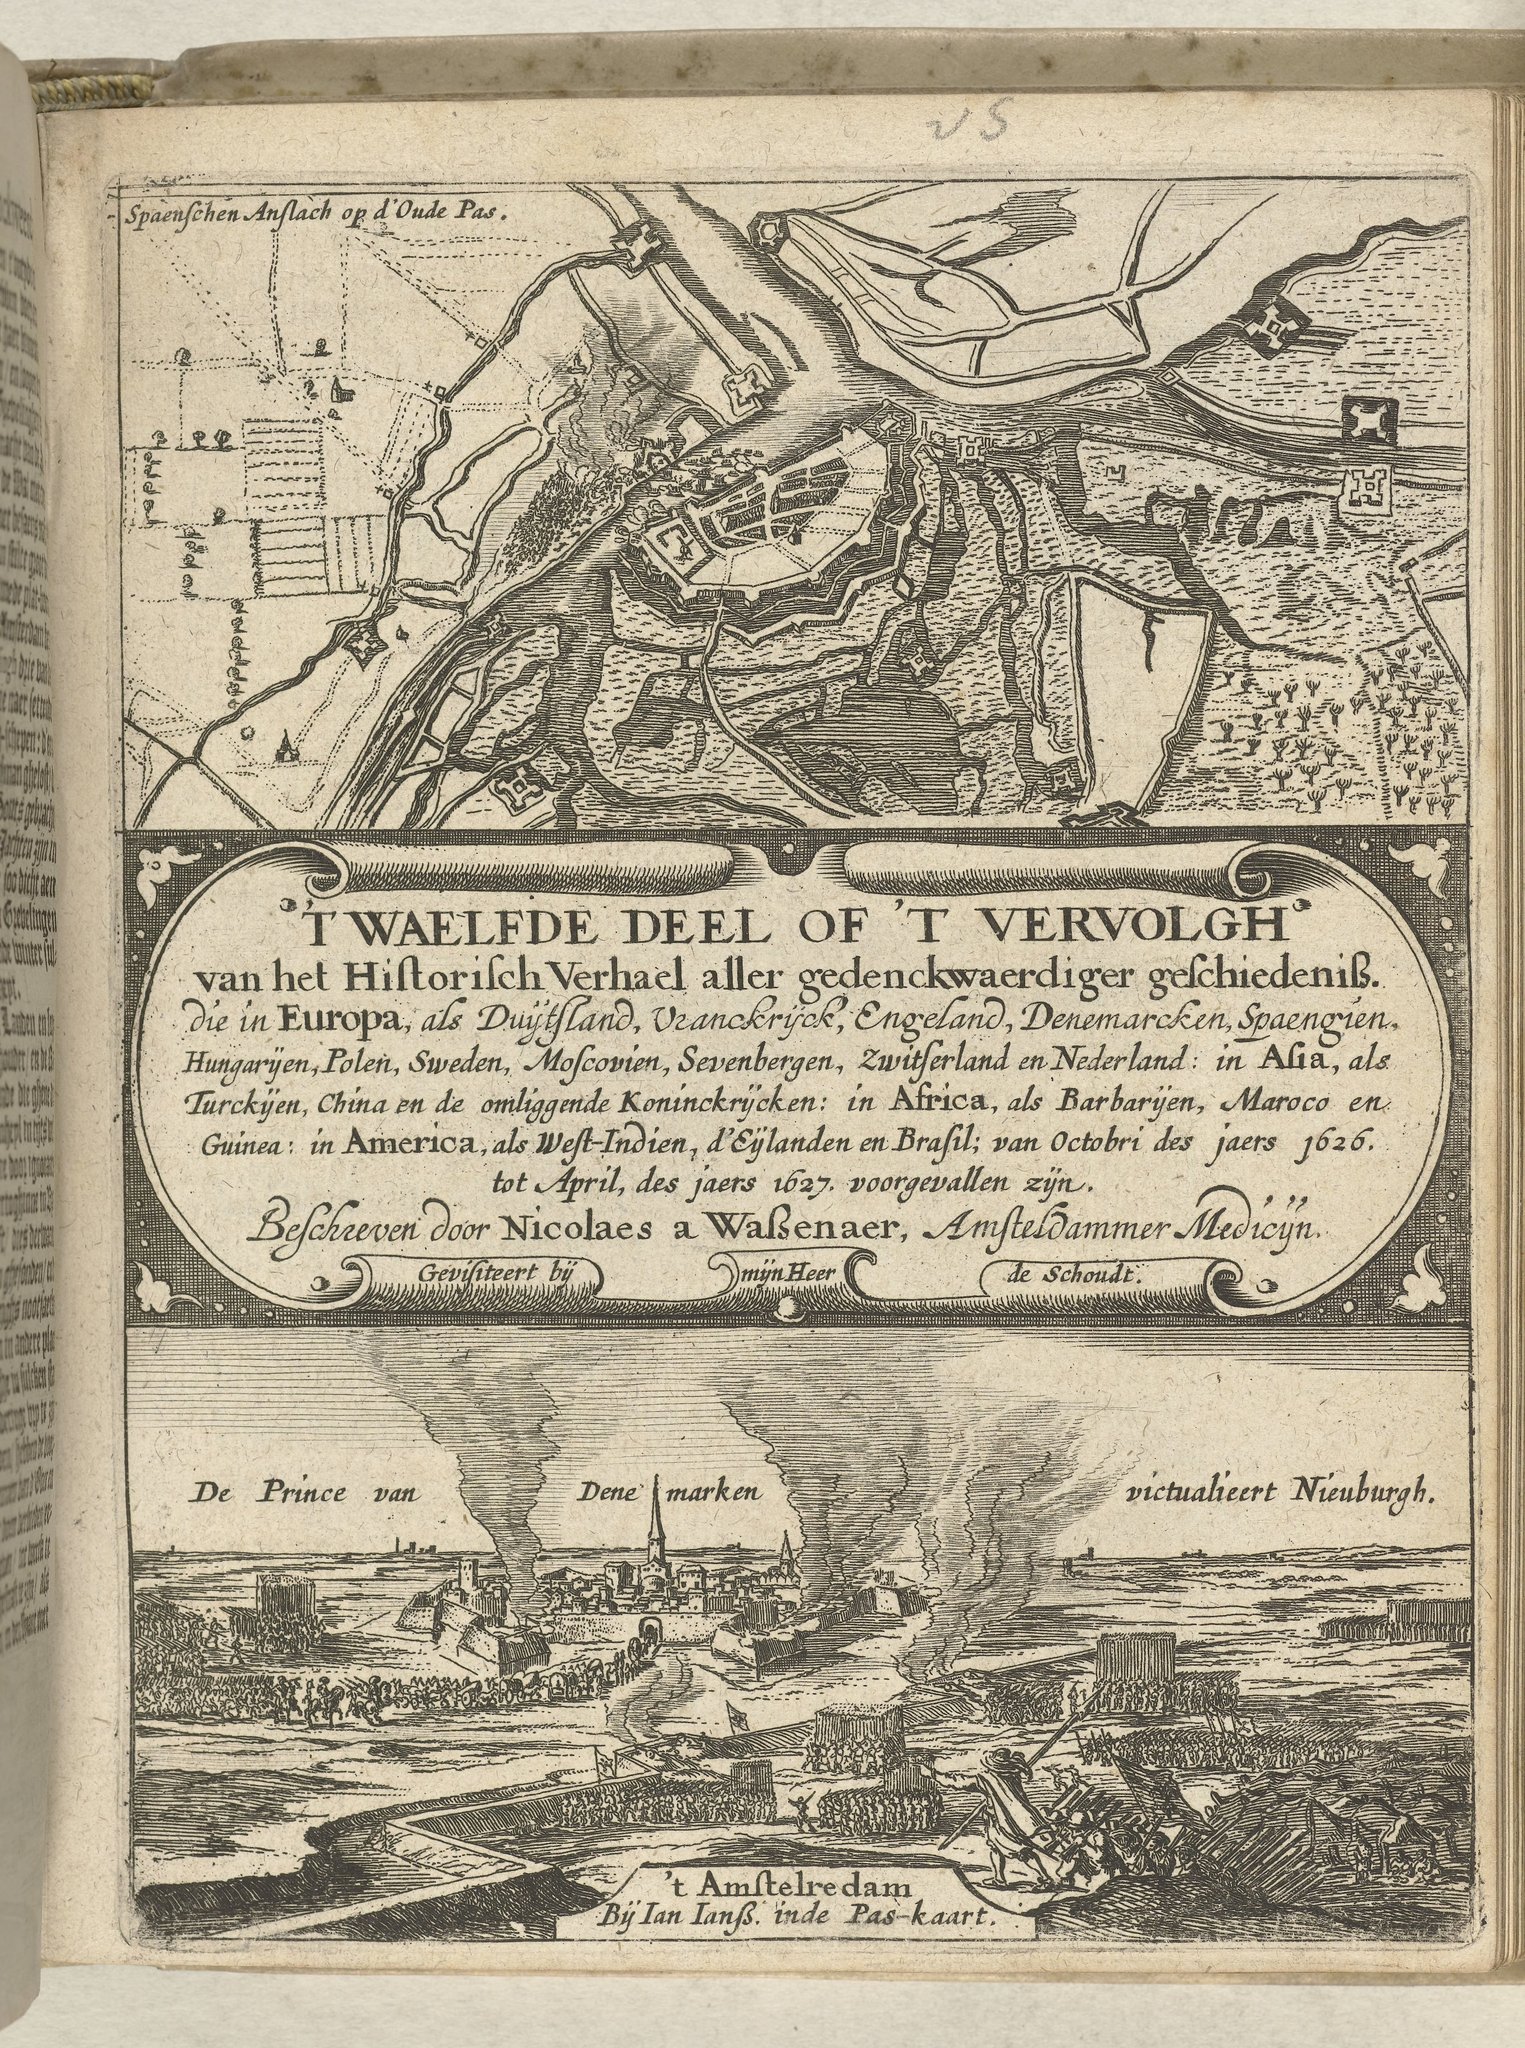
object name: print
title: 'T Waelfde Deel of 'T Vervolgh van het Historisch Verhael aller gedenckwaerdiger geschiedeniss. die in Europa, als Duijtsland, Vranckrijck, Engeland (...) Nederland: in Asia (...) in Africa (...) in America (...) van Octobri des jaers 1626. tot April, des jaers 1627. voorgevallen zijn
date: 1626-1627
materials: paper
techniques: etching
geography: northern netherlands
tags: copenhagen (city), christiaan iv (koning van denemarken en noorwegen), transporting of food ~ military service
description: Titelblad van Historisch verhael, band 4 (dl. 12), 1626-1627. Titelblad met twee voorstellingen. Boven een Spaanse aanslag op de Oude Pas (Zuid-Beveland tegenover Sluis). Onder de bevoorrading van Neuburg door de koning van Denemarken. In het midden een cartouche met de titel.